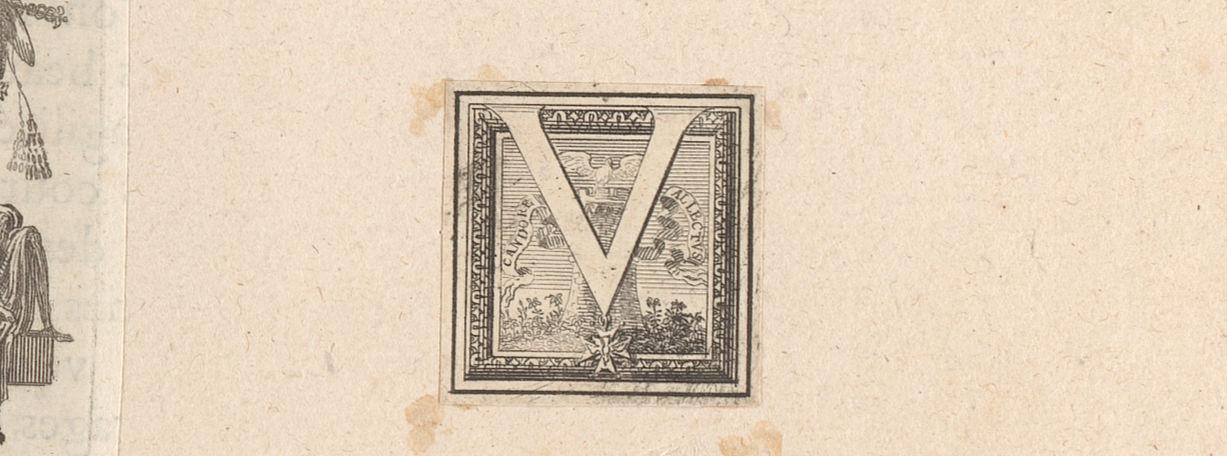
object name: book illustration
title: Initiaal 'V' met een duif op een toren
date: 1672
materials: paper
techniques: etching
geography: paris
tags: initial, landscape with tower or castle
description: Initiaal gebruikt voor: Le Houx, Jean. Recueil de poésies latines (...). Parijs: Jean Dupuys, 1672.